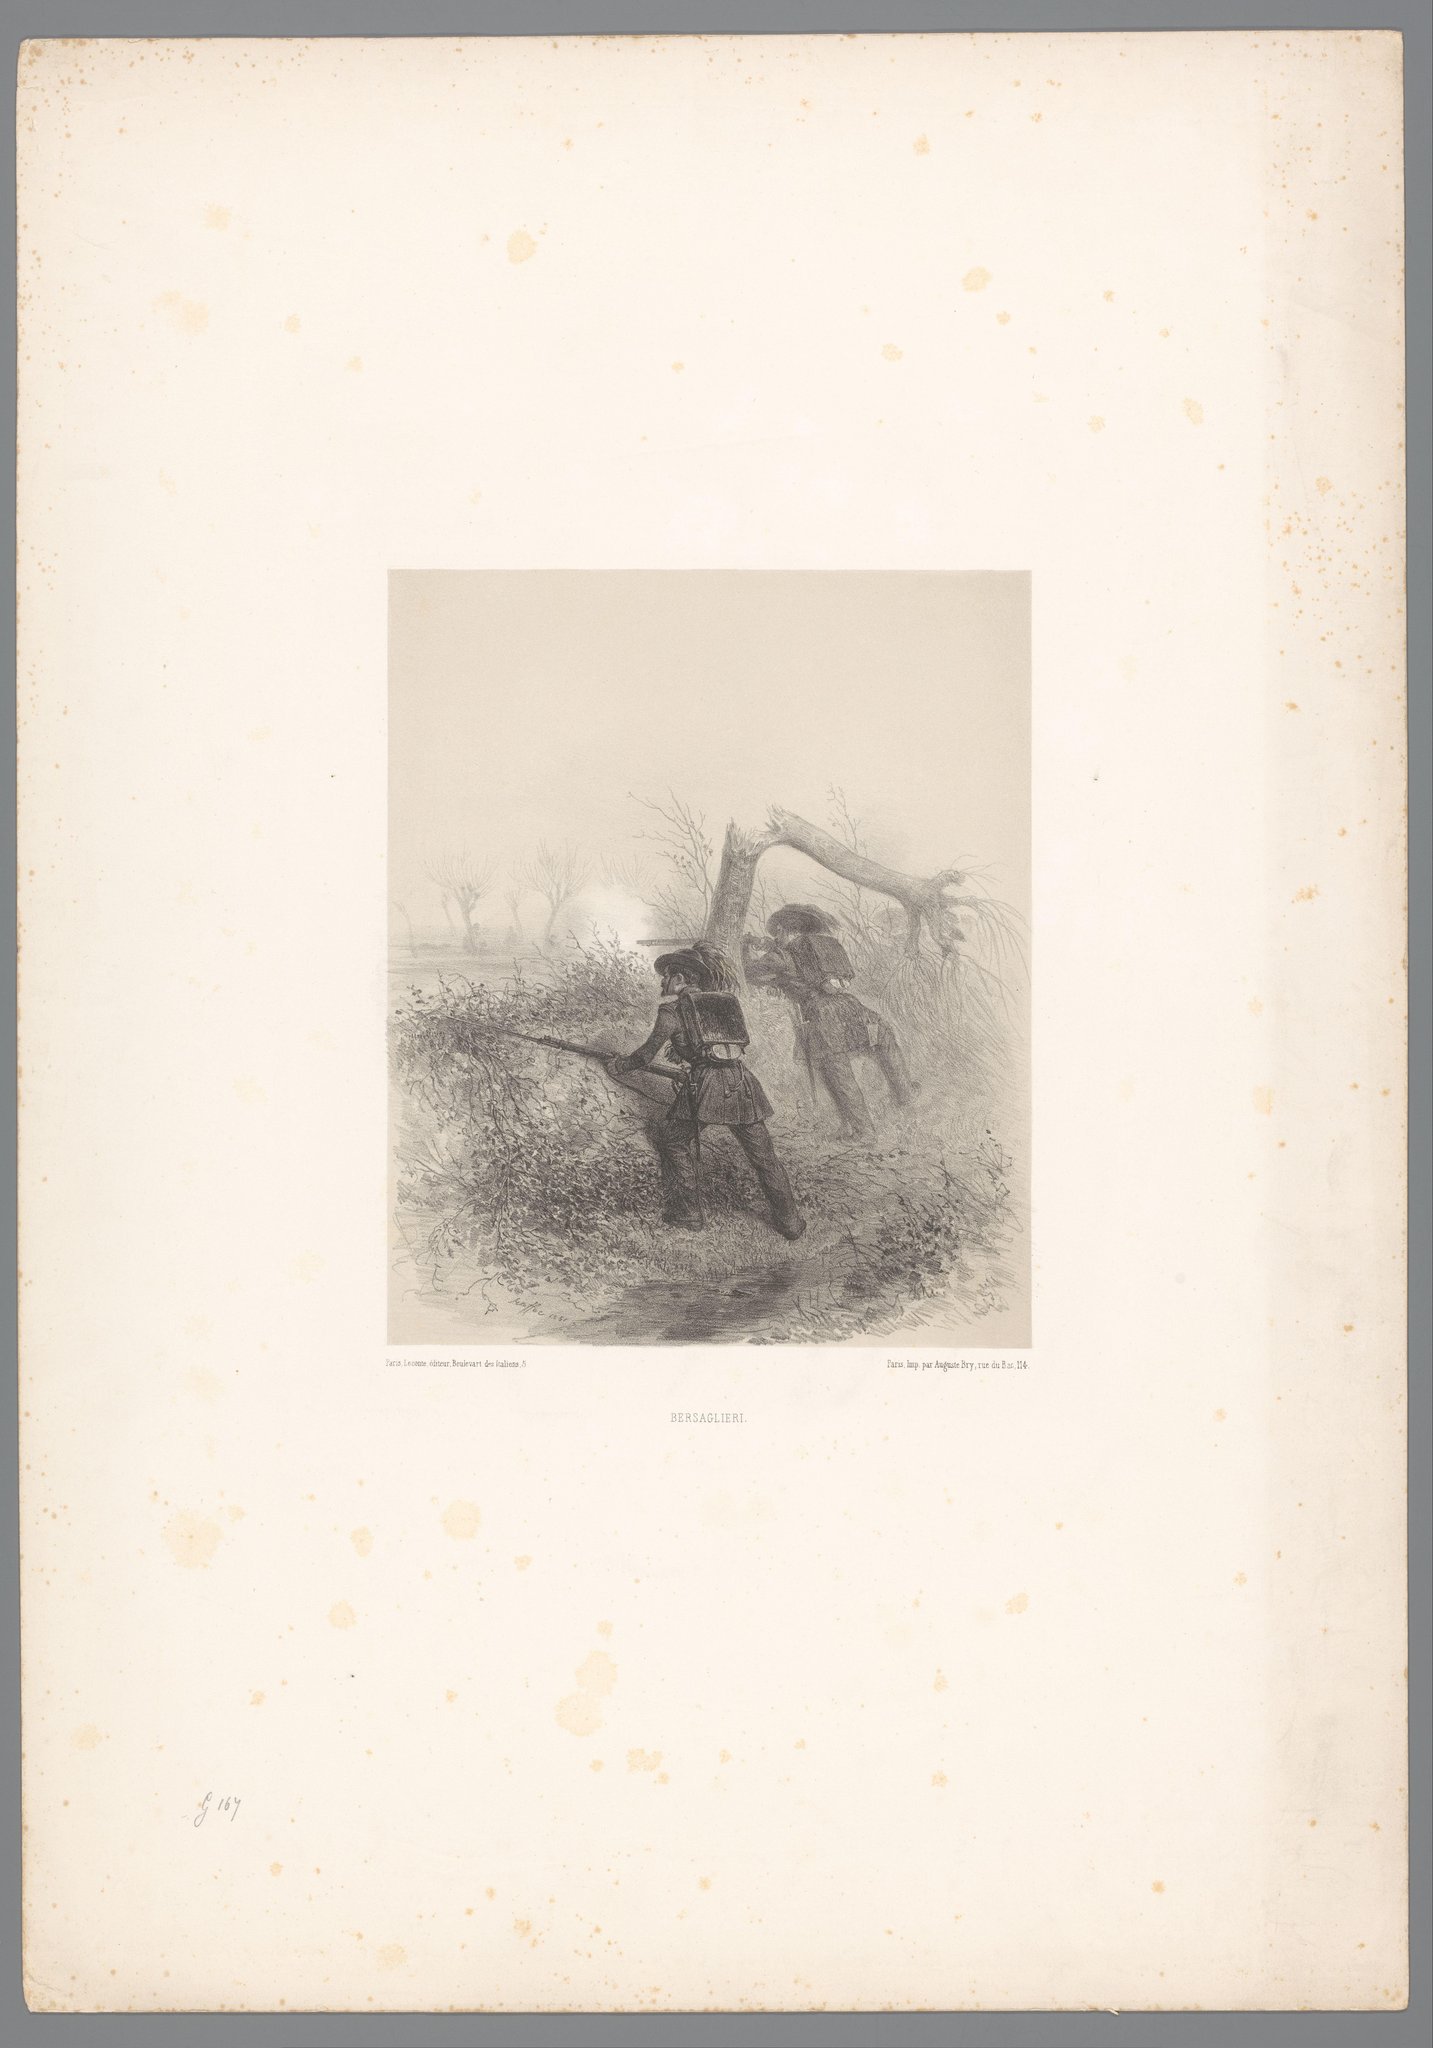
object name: print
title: Twee soldaten met geweer waarvan er een vuurt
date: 1851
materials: paper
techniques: tone lithography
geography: paris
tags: firearms: rifle, the soldier; the soldier's life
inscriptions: collector's mark: Lugt 964